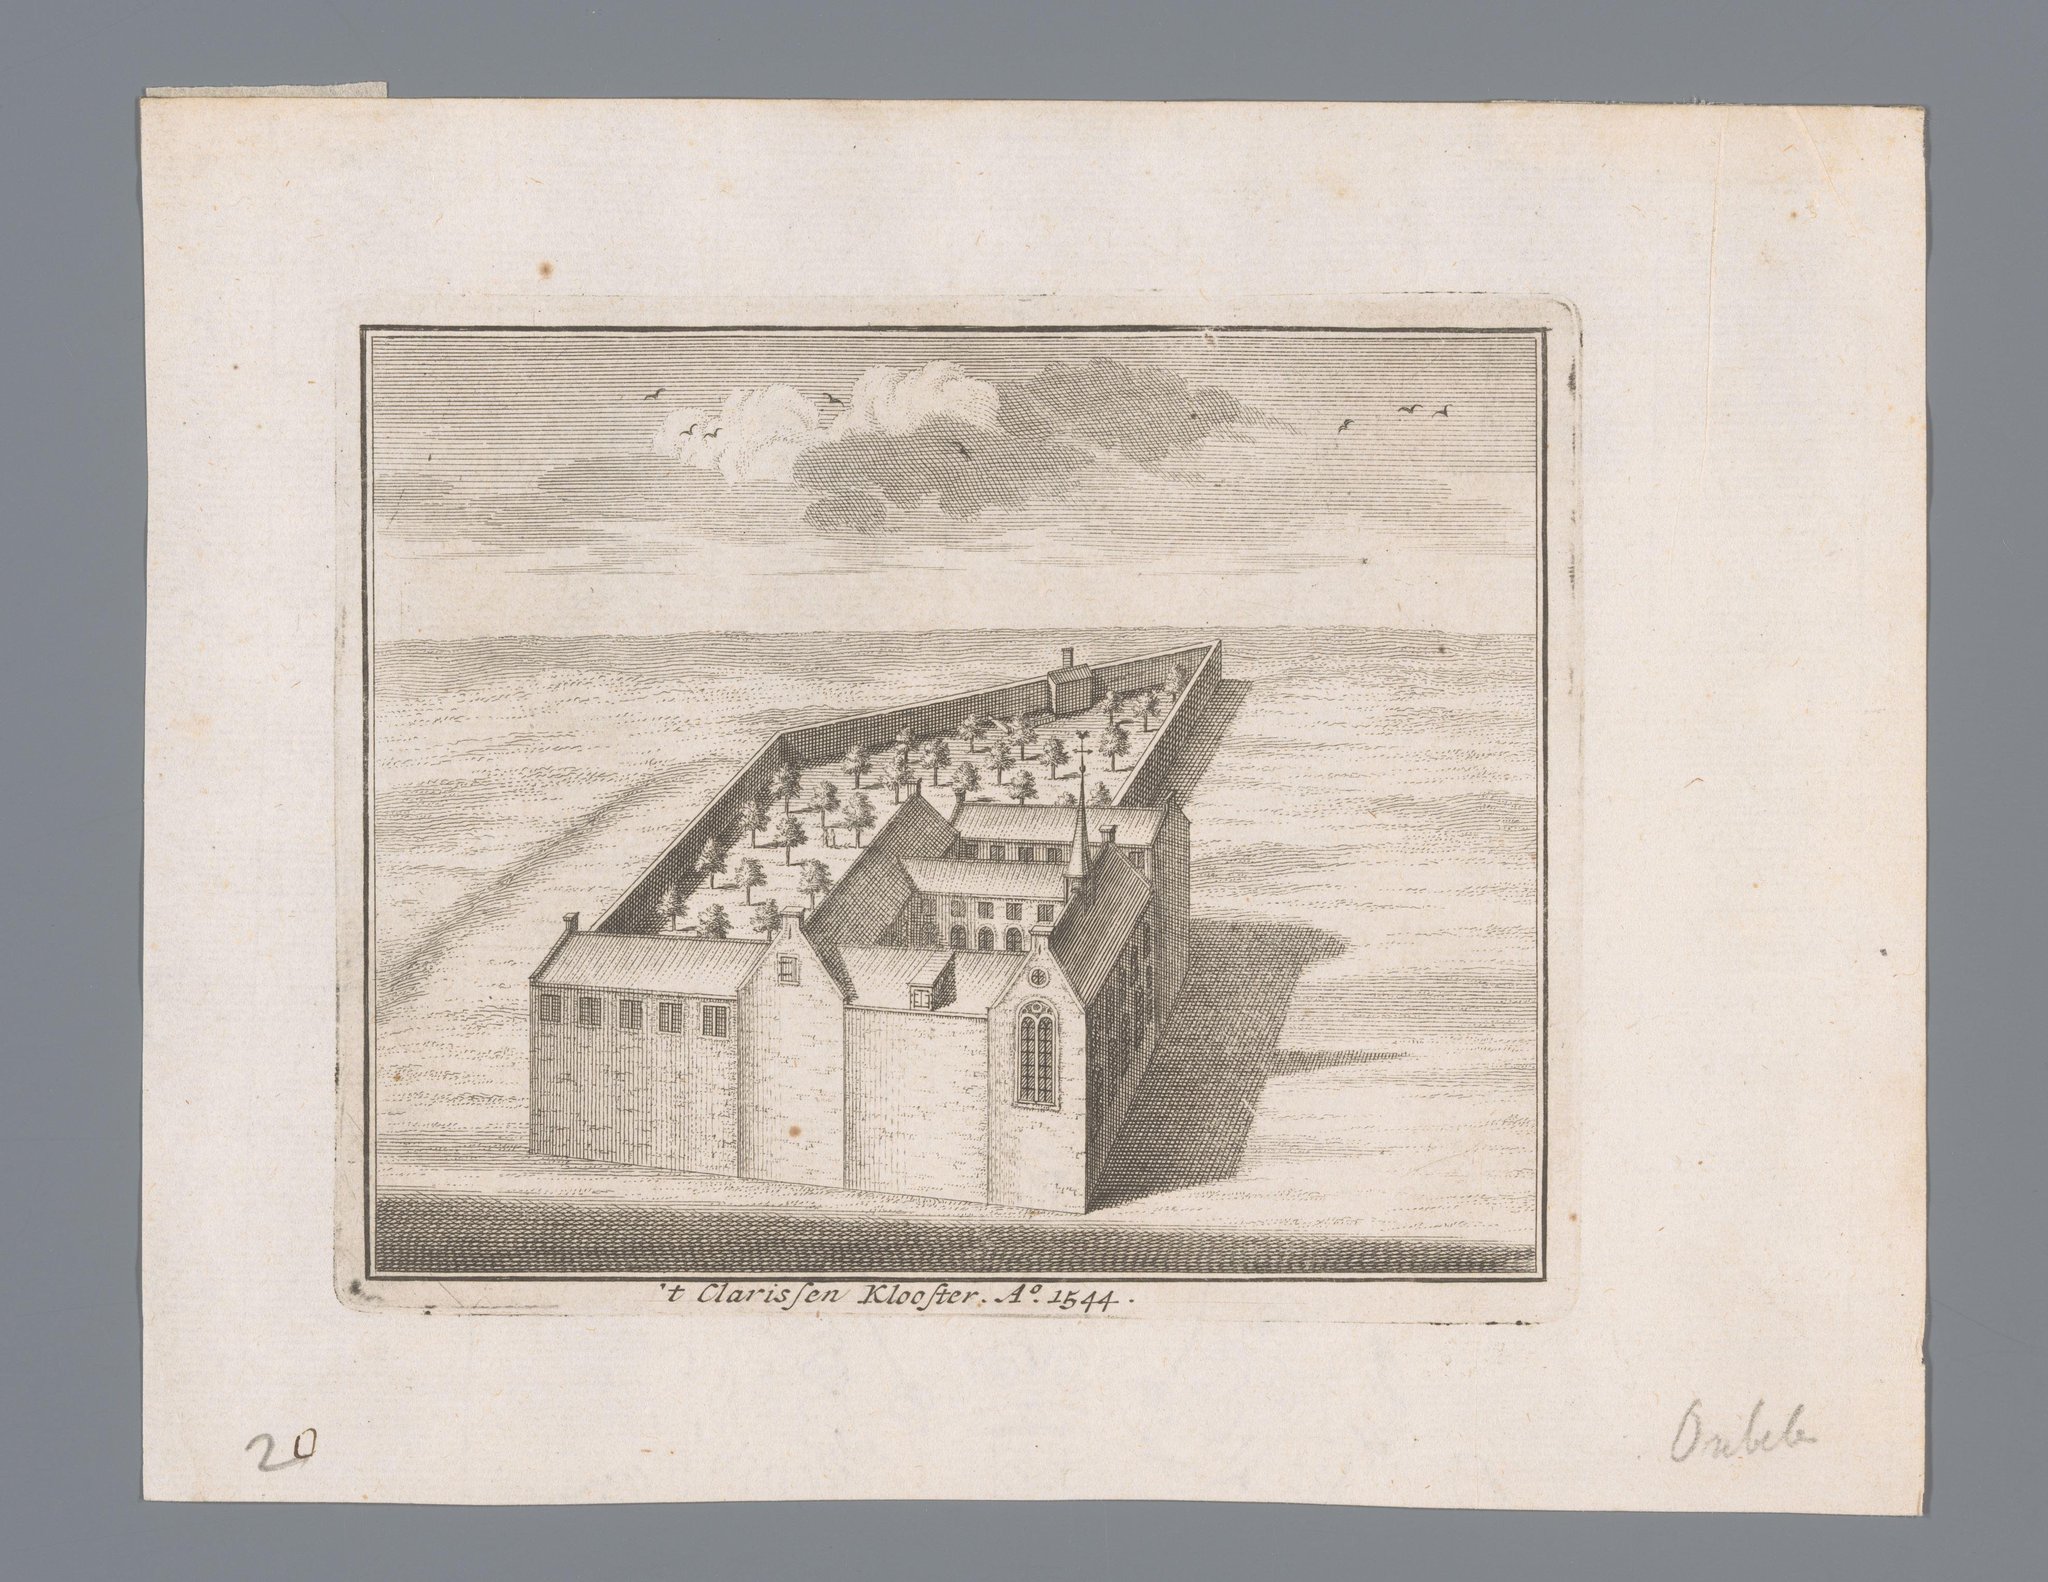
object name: print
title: 't Clarissen Klooster. Ao. 1544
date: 1729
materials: paper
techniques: etching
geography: amsterdam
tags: abbey, monastery, convent ~ roman catholic church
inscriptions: watermark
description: Prent verschenen in: Long, Isaak Le. Historische beschryvinge van de Reformatie der stadt Amsterdam. Amsterdam: Johannes van Septeren, 1729.